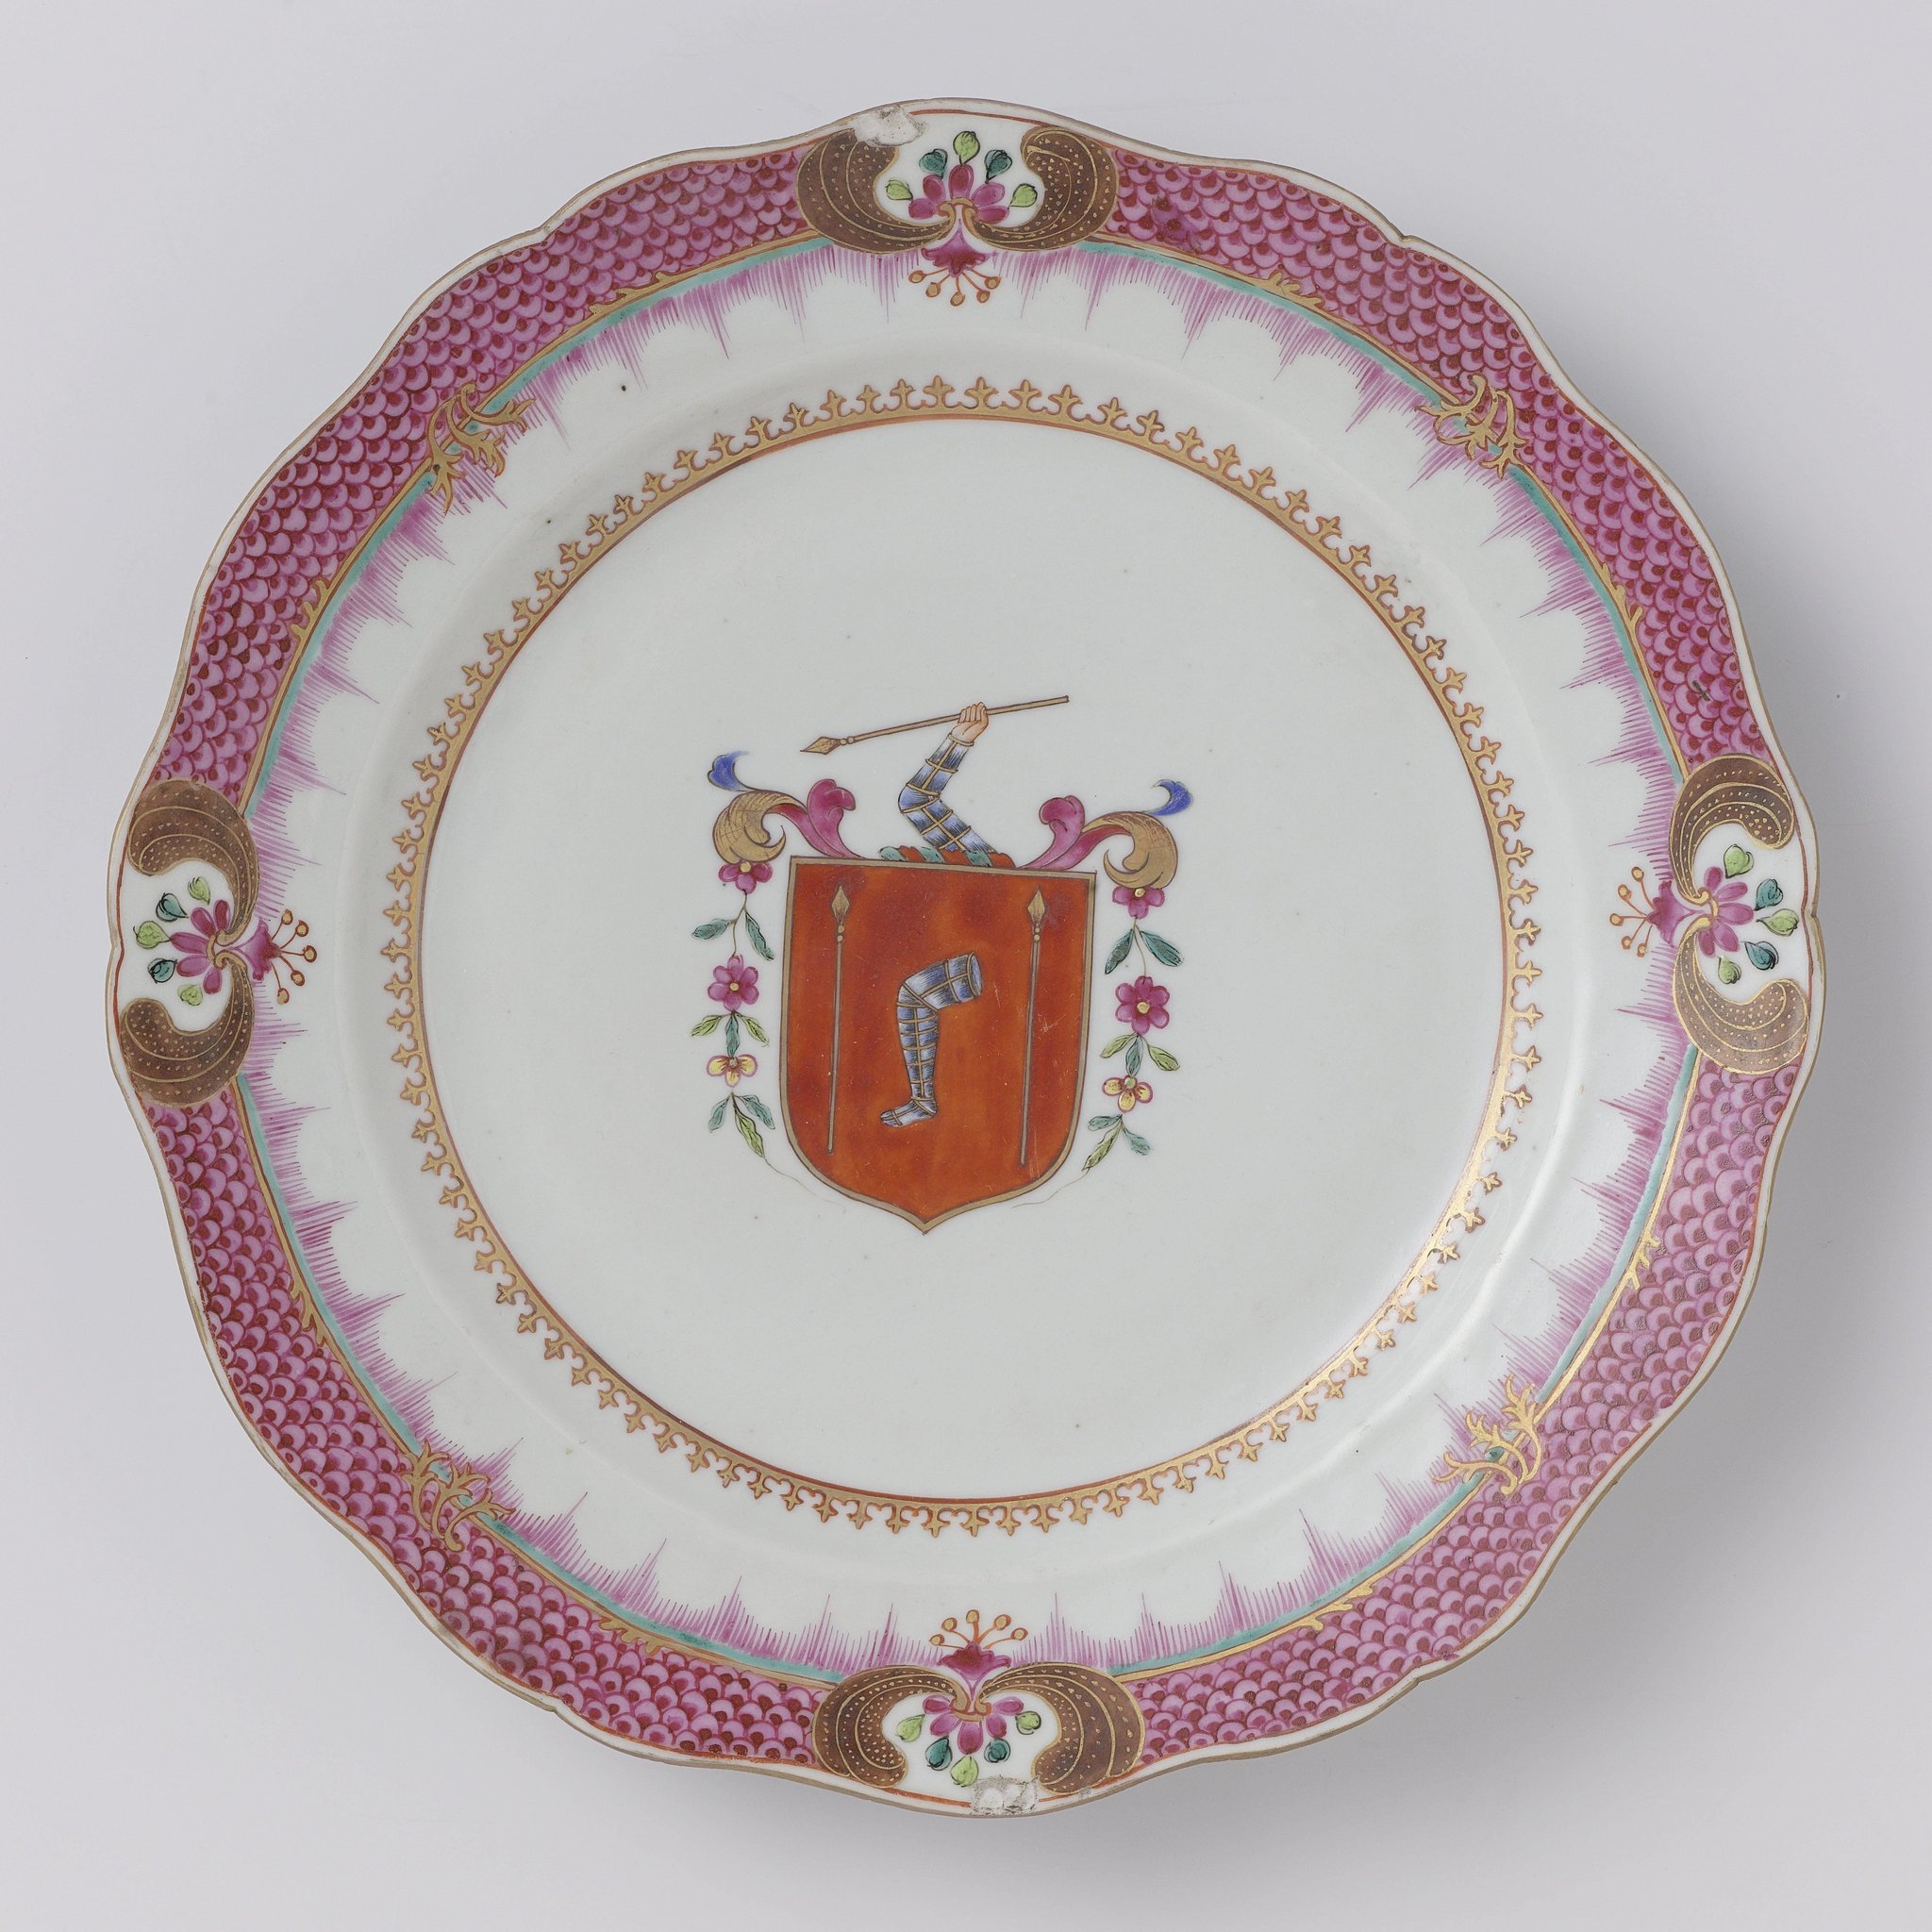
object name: plate dish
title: Plate with the arms of the Gilbert family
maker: Anonymous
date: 1750-1774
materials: glaze, gold, paint, porcelain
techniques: firing, gilding, turning, vitrification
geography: china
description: Bord van porselein met goschulpte rand, beschilderd op het glazuur in blauw, rood, roze, groen, geel, zwart en goud. Op het plat het wapen van de familie Gilbert omgeven door bladranken en bloemtakken. De wand met een spearhead-border. Op de rand een decoratieve band onderbroken door vier cartouches met een gestileerde bloem. Twee chips in de rand. Wapenporselein met emailkleuren.